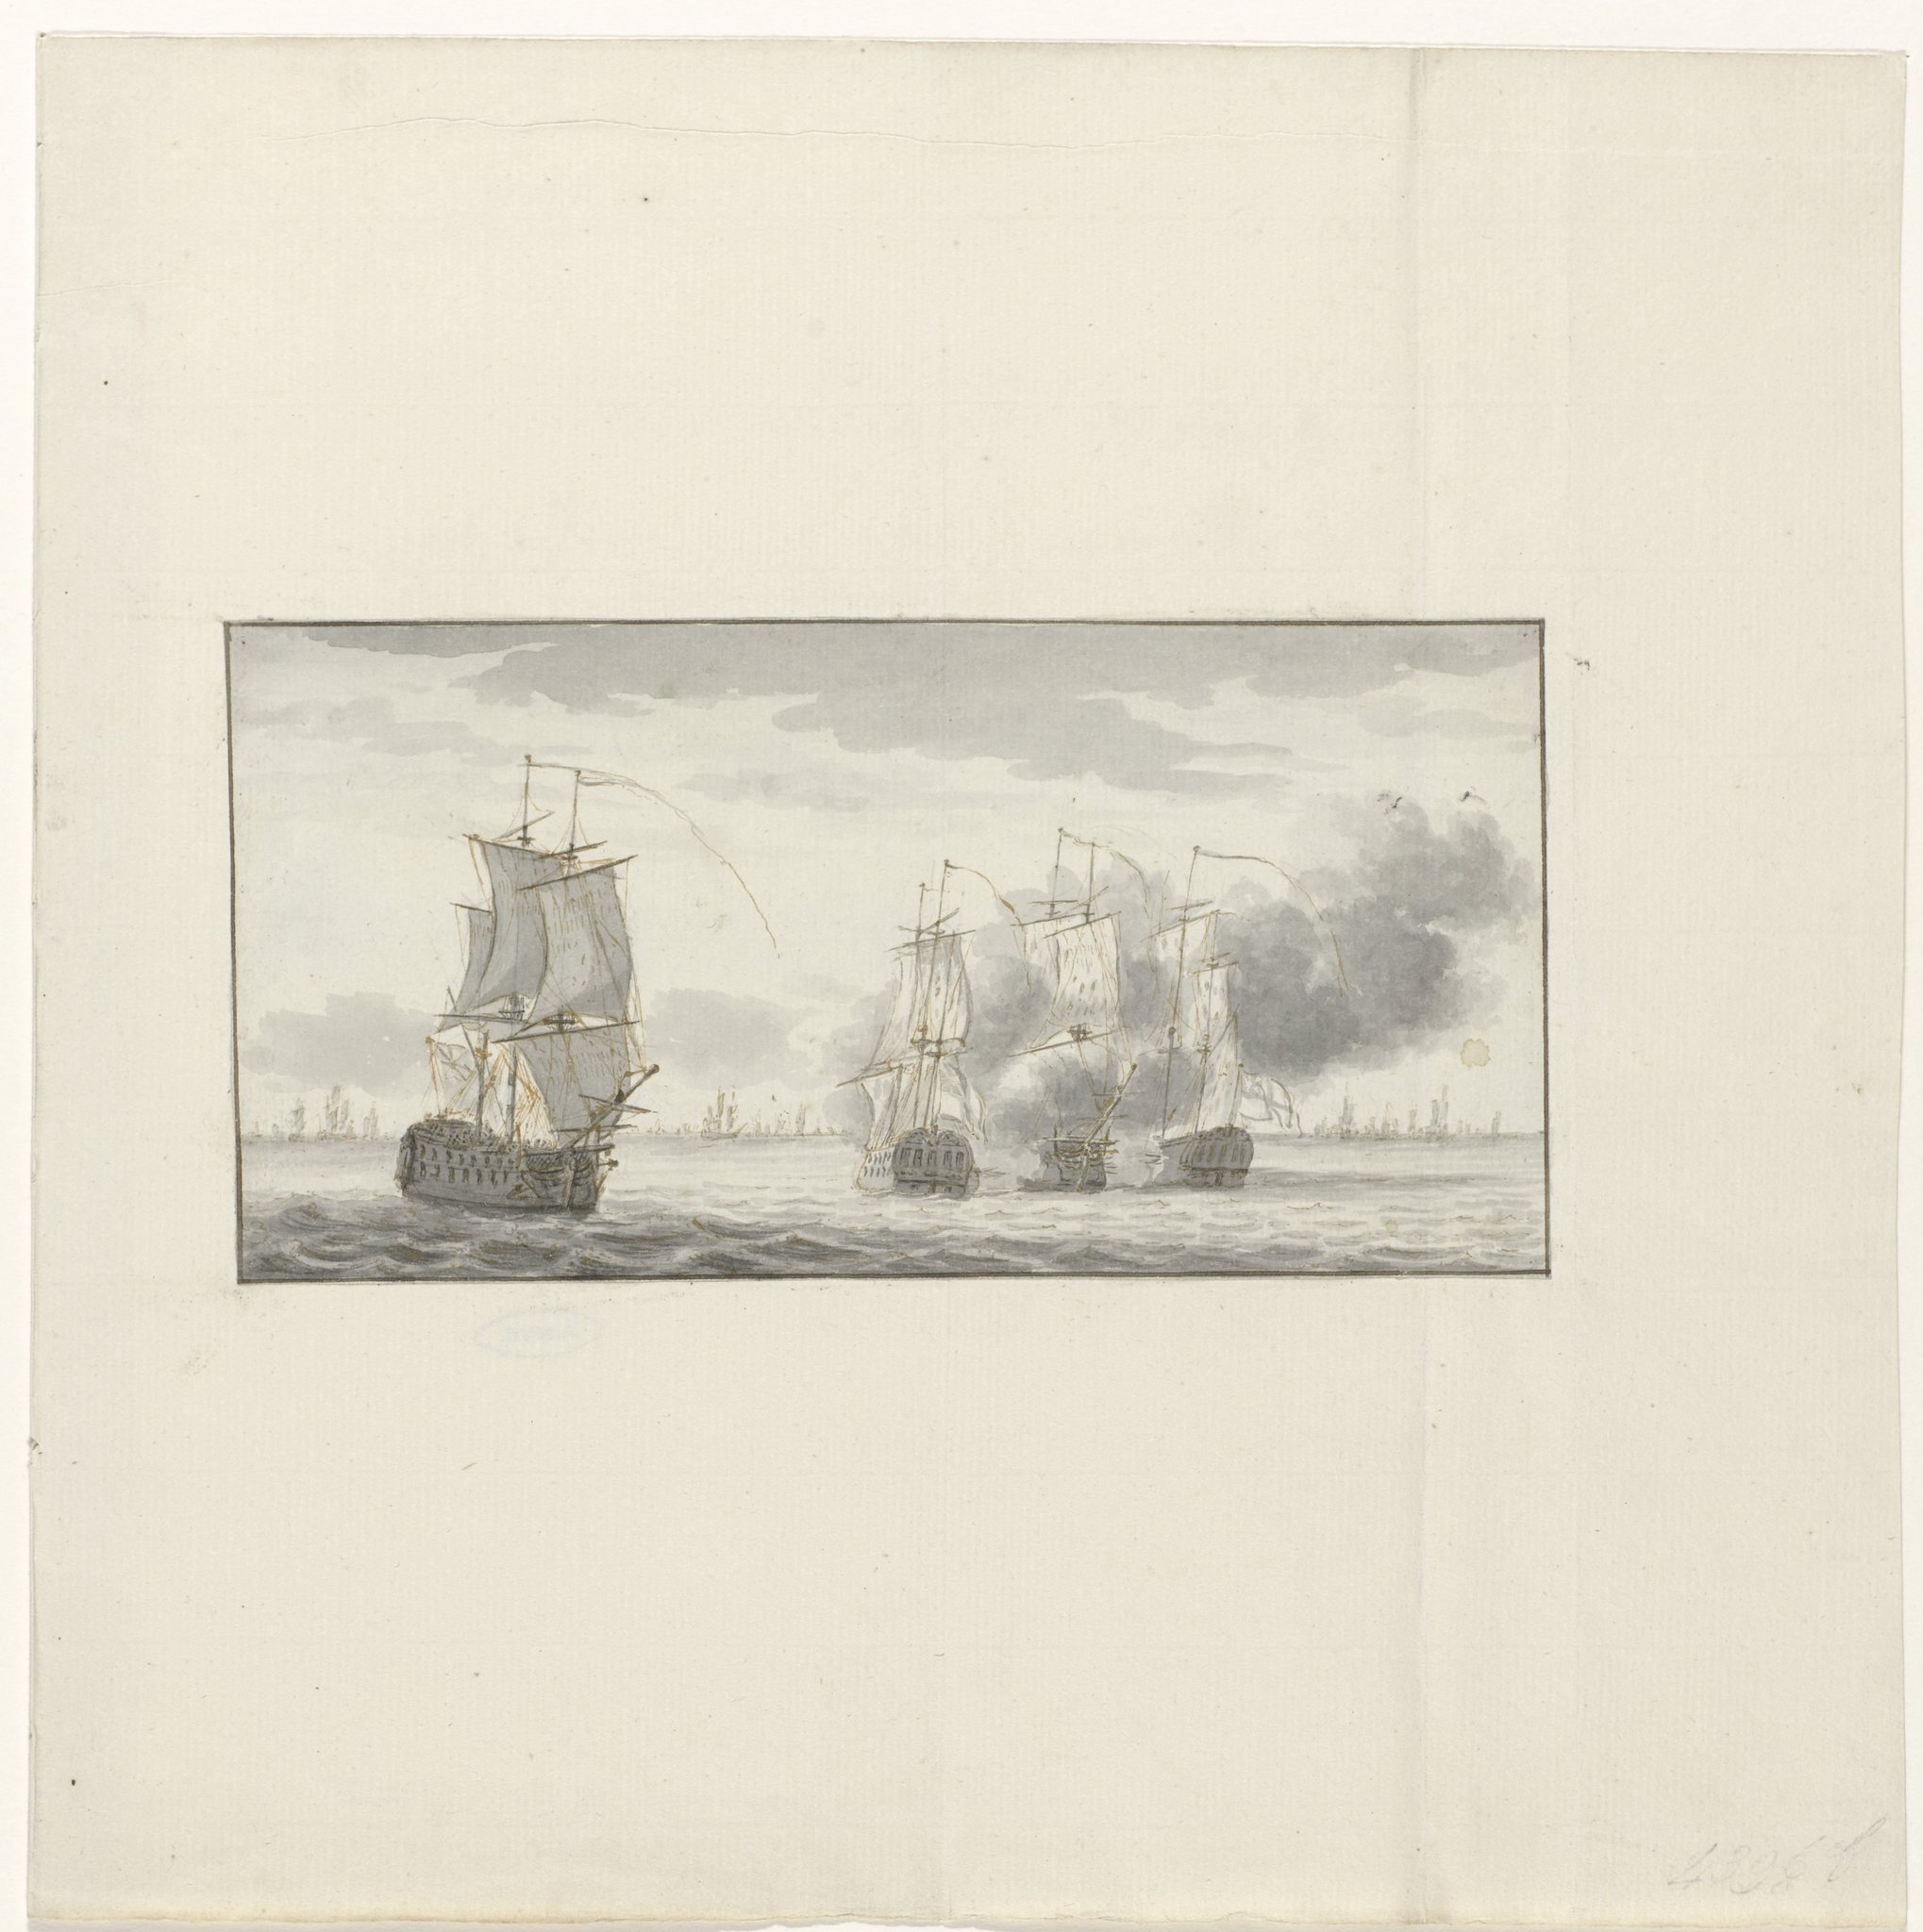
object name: drawing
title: Willem Crul aangevallen door de Engelsen, 1781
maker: carel frederik bendorp (i)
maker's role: print maker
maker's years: 1736-1814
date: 1781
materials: paper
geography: northern netherlands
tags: haarlem, battle (+ naval force)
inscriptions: collector's mark: Lugt 2228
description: Het Nederlandse oorlogsschip Mars onder bevel van schout-bij-nacht Willem Crul aangevallen door drie Engelse oorlogsschepen op 4 februari 1781. De Mars begeleidde een konvooi Nederlandse koopvaarders van Sint-Eustatius. Ontwerp voor een prent.